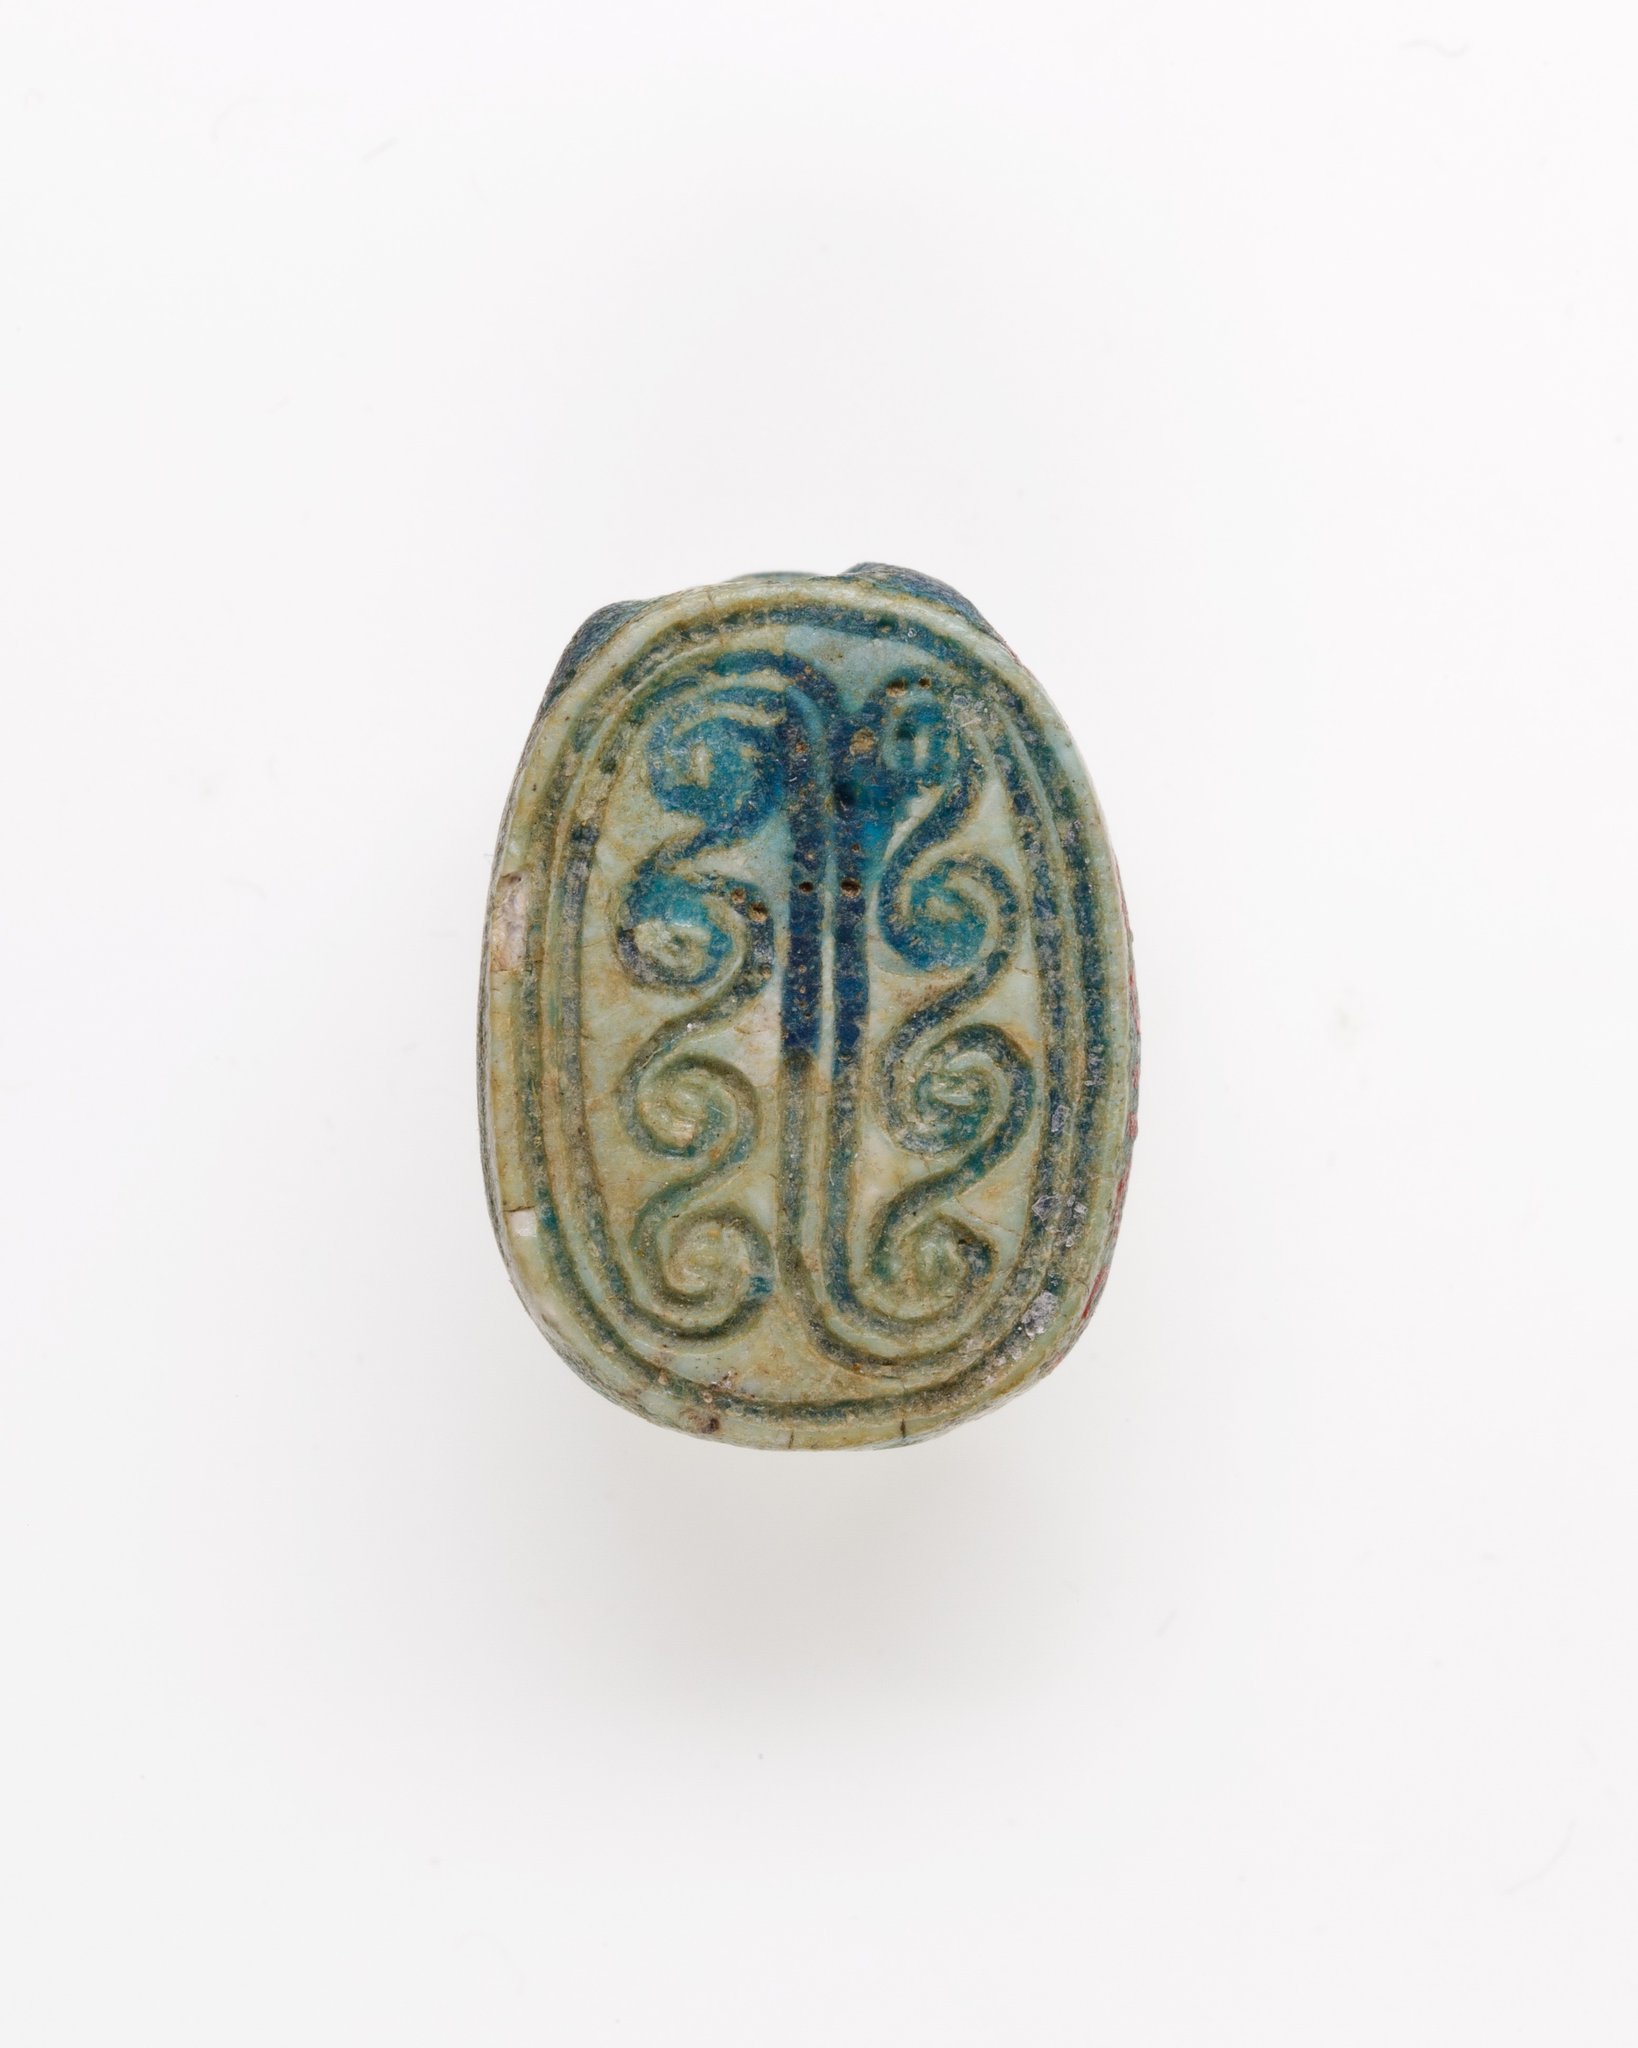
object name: scarab, scroll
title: Scarab Decorated with Scrolls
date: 1740-1640 BCE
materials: stone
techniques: glazing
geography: egypt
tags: scarabs